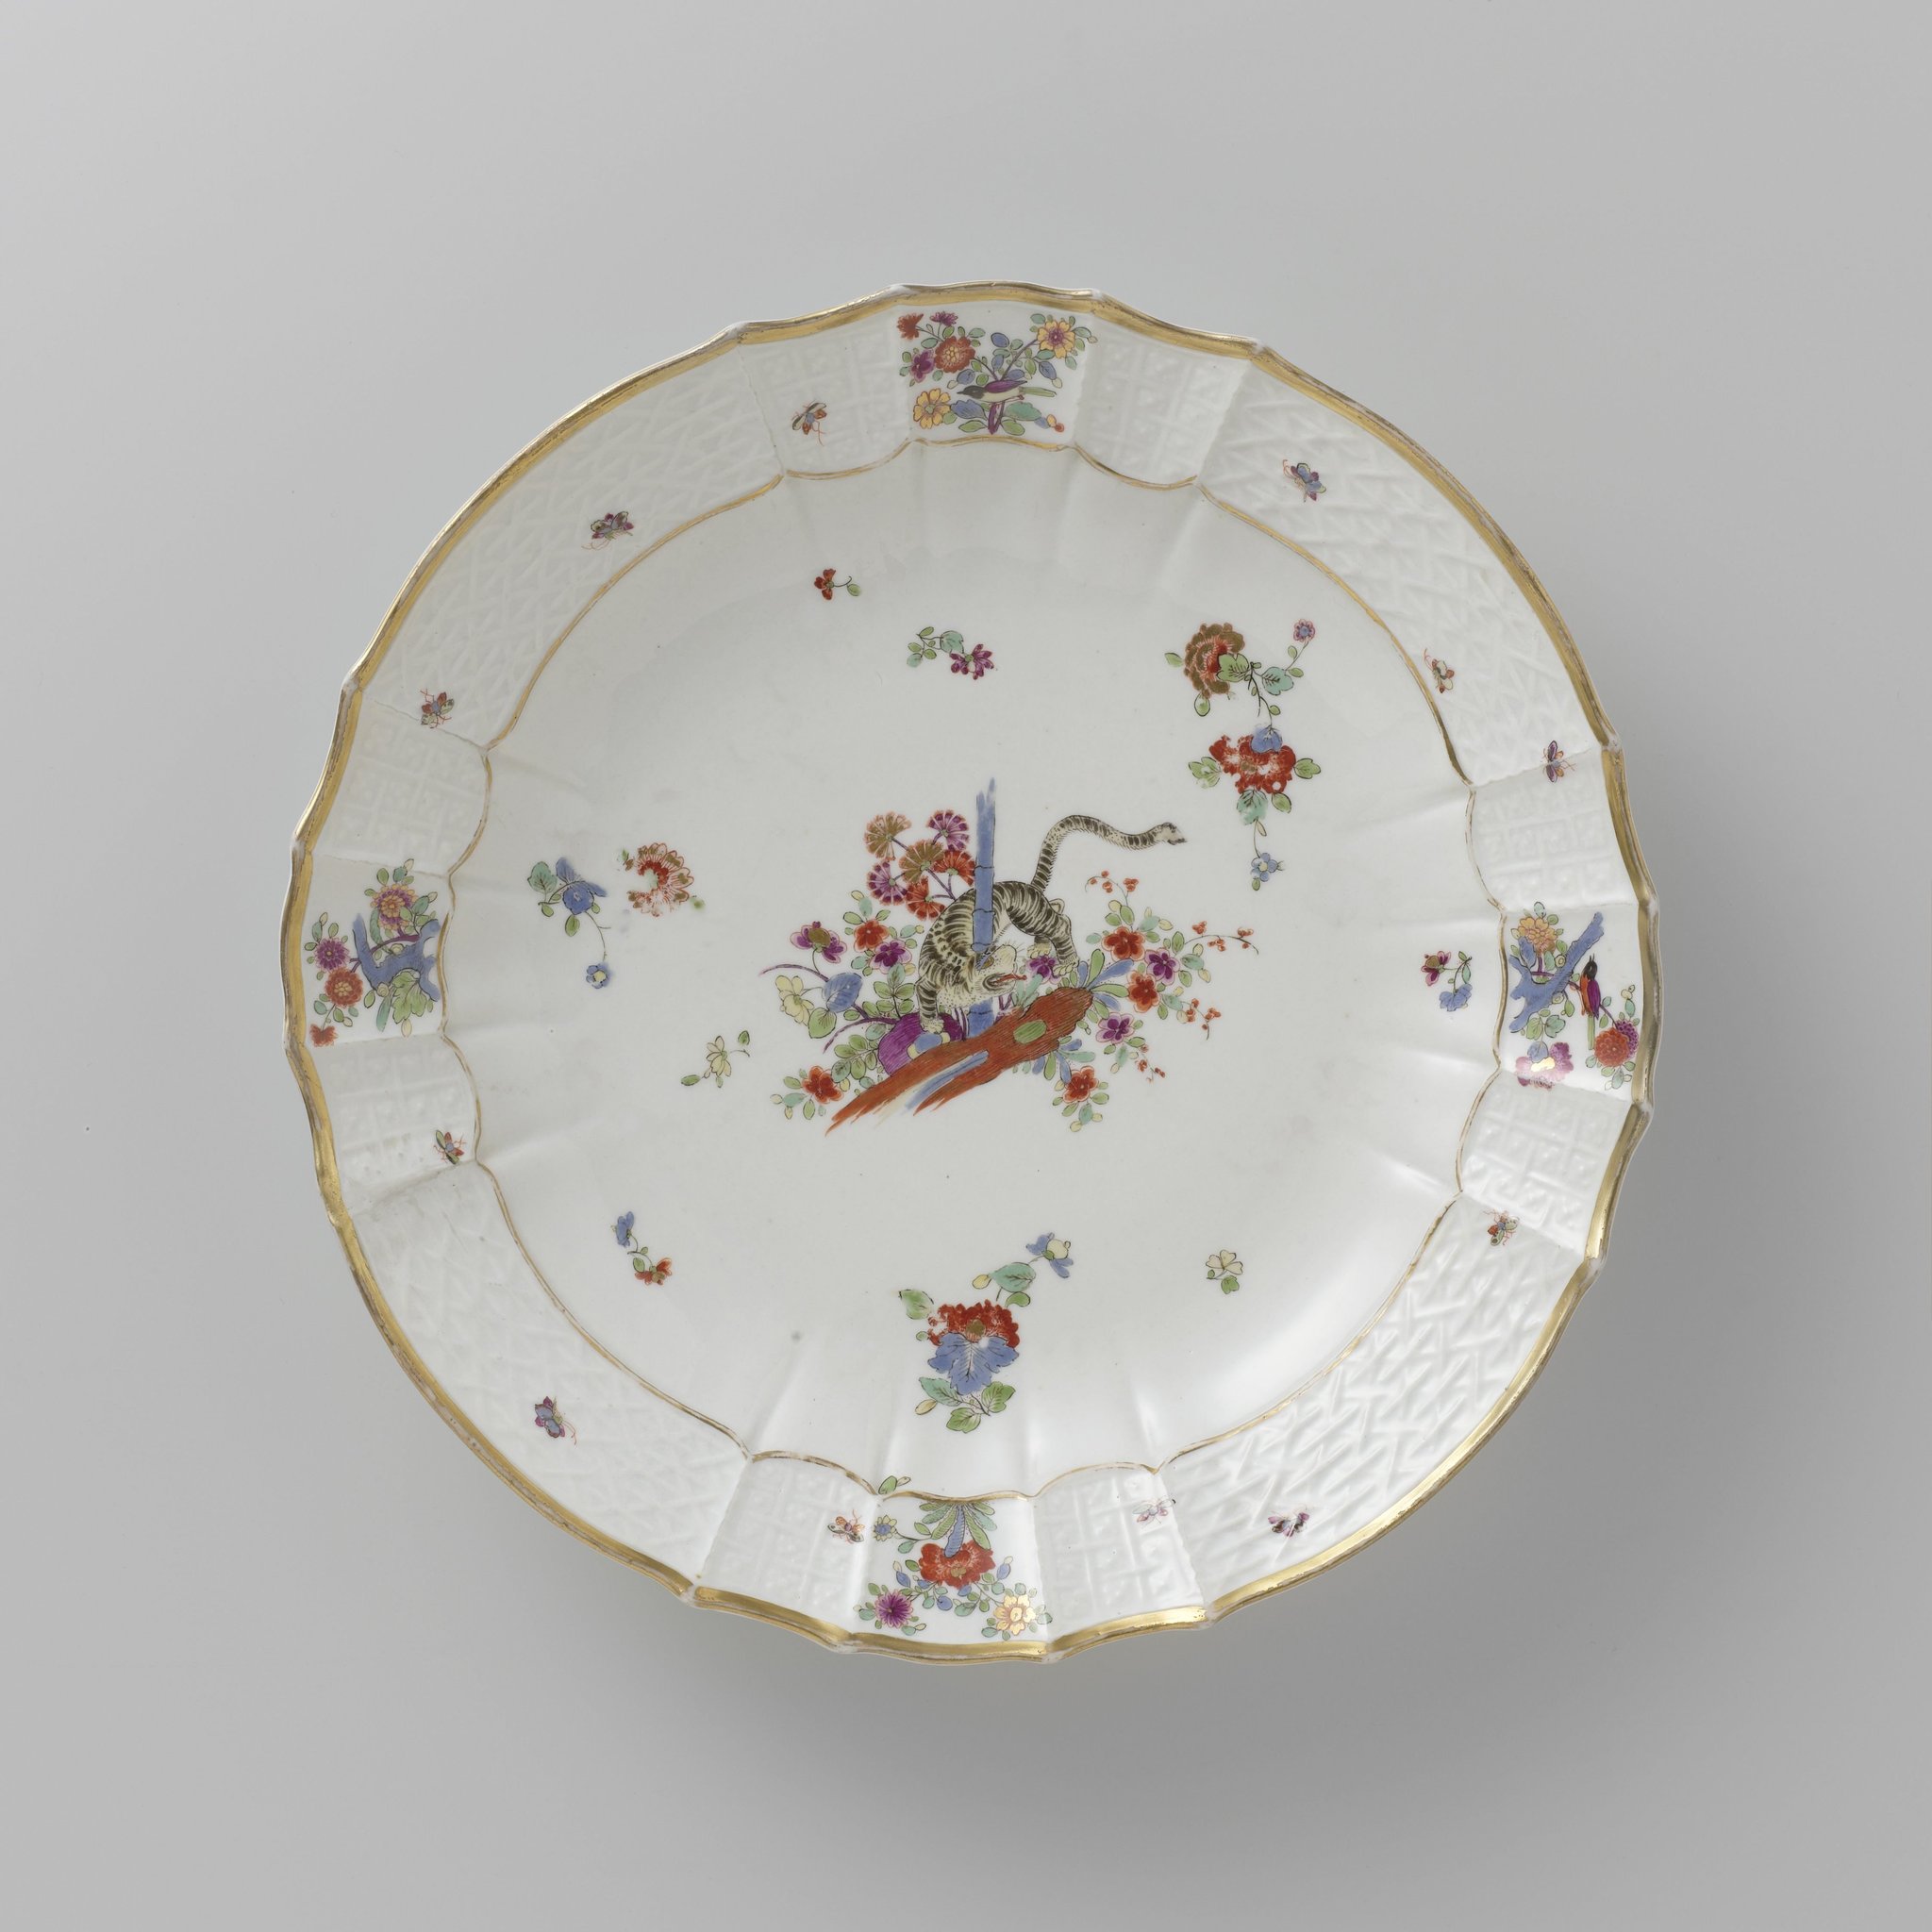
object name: platter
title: Schotel, veelkleurig beschilderd met een Kakiemon-decor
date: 1740-1745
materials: porcelain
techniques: painted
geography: meissen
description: Ronde schotel van beschilderd porselein. De schotel heeft een geribde en geschulpte rand. De schotel is beschilderd met een tijger om een bamboestengel, gestrooide Indianische Blumen, vlinders en takken met vogels. De rand is versierd met het 'Altbrandenstein'-patroon. De schotel is gemerkt.